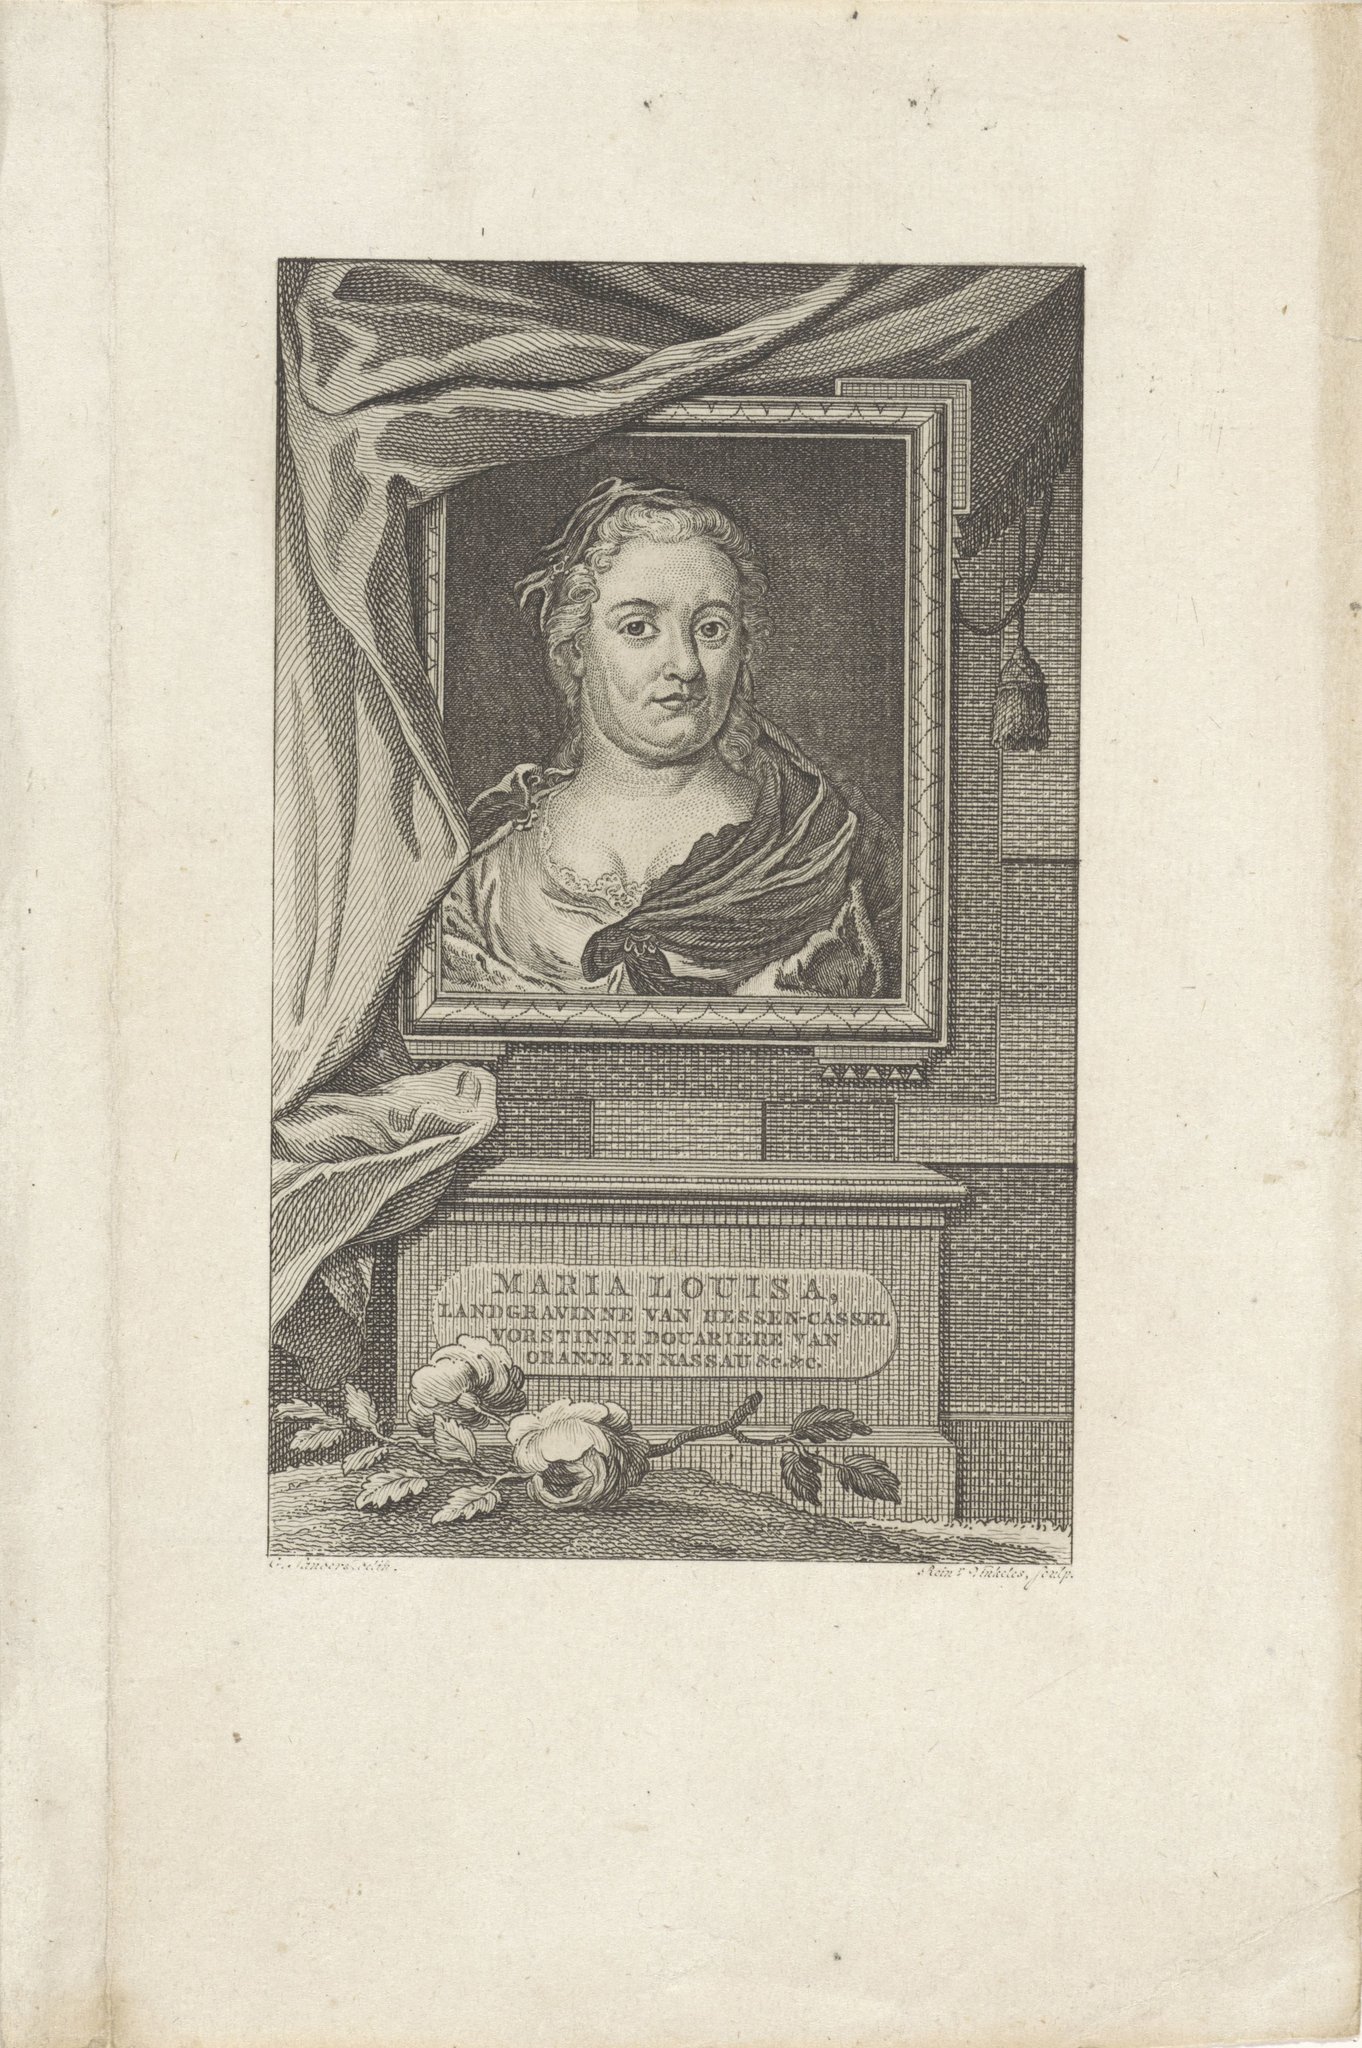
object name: print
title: Portret van Maria Louise, prinses van Oranje-Nassau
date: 1786-1809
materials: paper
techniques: etching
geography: amsterdam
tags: maria louisa van hessen-kassel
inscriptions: collector's mark: Lugt 2228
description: Prent vermoedelijk ook gebruikt als boekillustratie in: Wagenaar, Jan. Vaderlandsche historie, (...) ten vervolge van Wagenaars Vaderlandsche historie. Dl. 1-43. Amsterdam: Johannes Allart, 1786-1809.